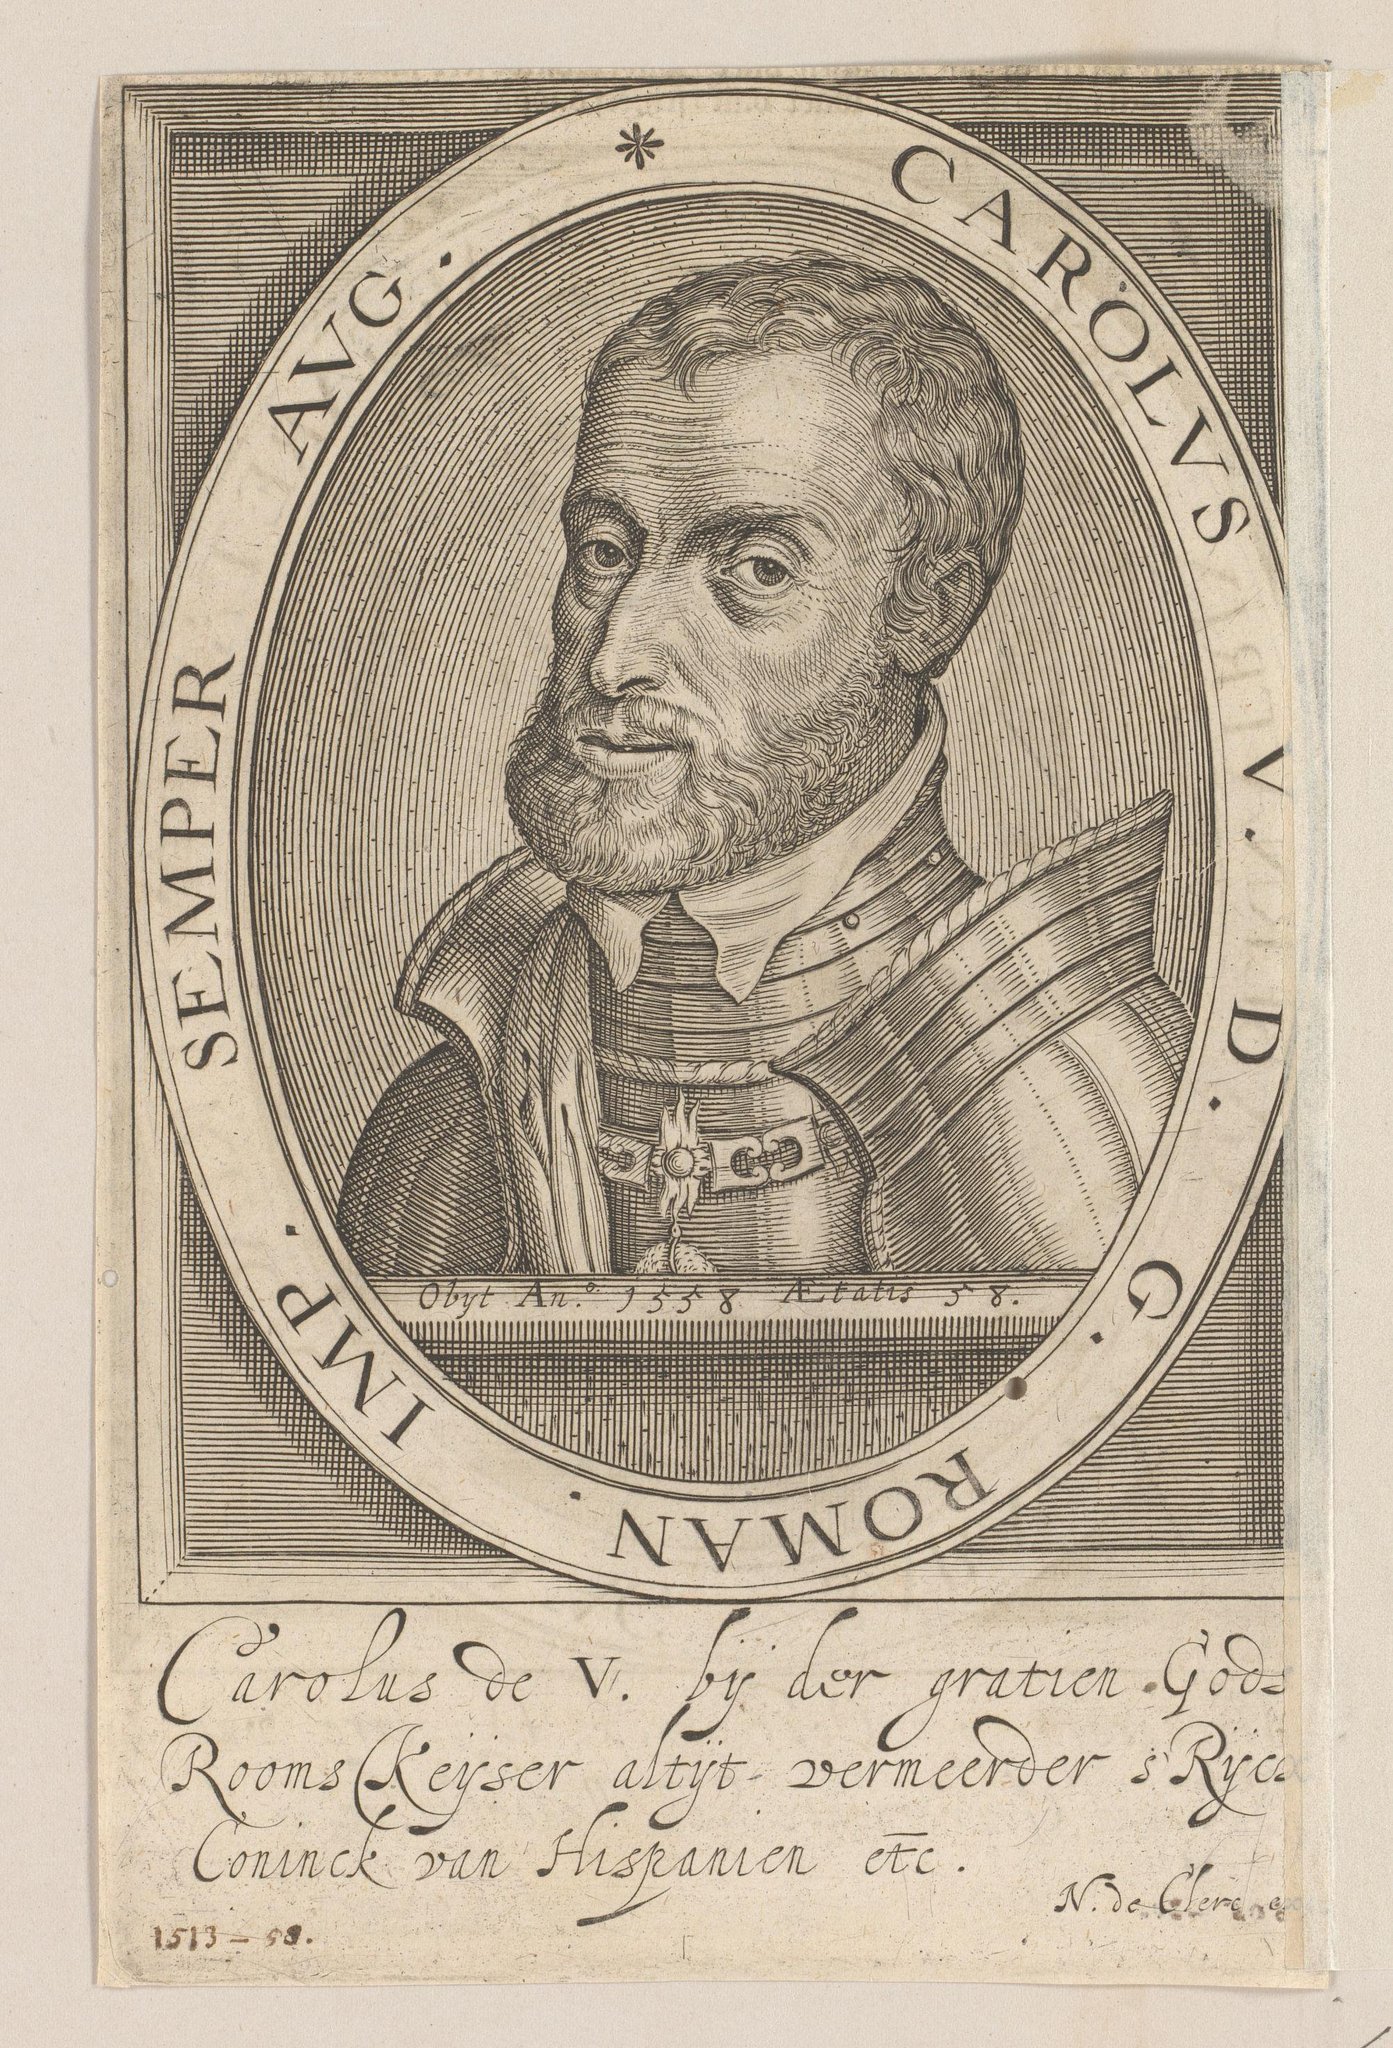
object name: print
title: Portret van keizer Karel V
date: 1614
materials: paper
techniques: engraving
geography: the hague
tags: ghent, charles v (holy roman emperor and king of spain), ornament ~ medallion, historical persons, emperor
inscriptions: inscription: ‘1513-58’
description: Prent uit: Meteren, Emanuel van. Historie der Neder-landscher ende haerder Na-buren Oorlogen ende geschiedenissen (...). Den Haag: Hillebrant Jacobsz. van Wouw, 1614. Mogelijk ook gebruikt in andere publicaties.